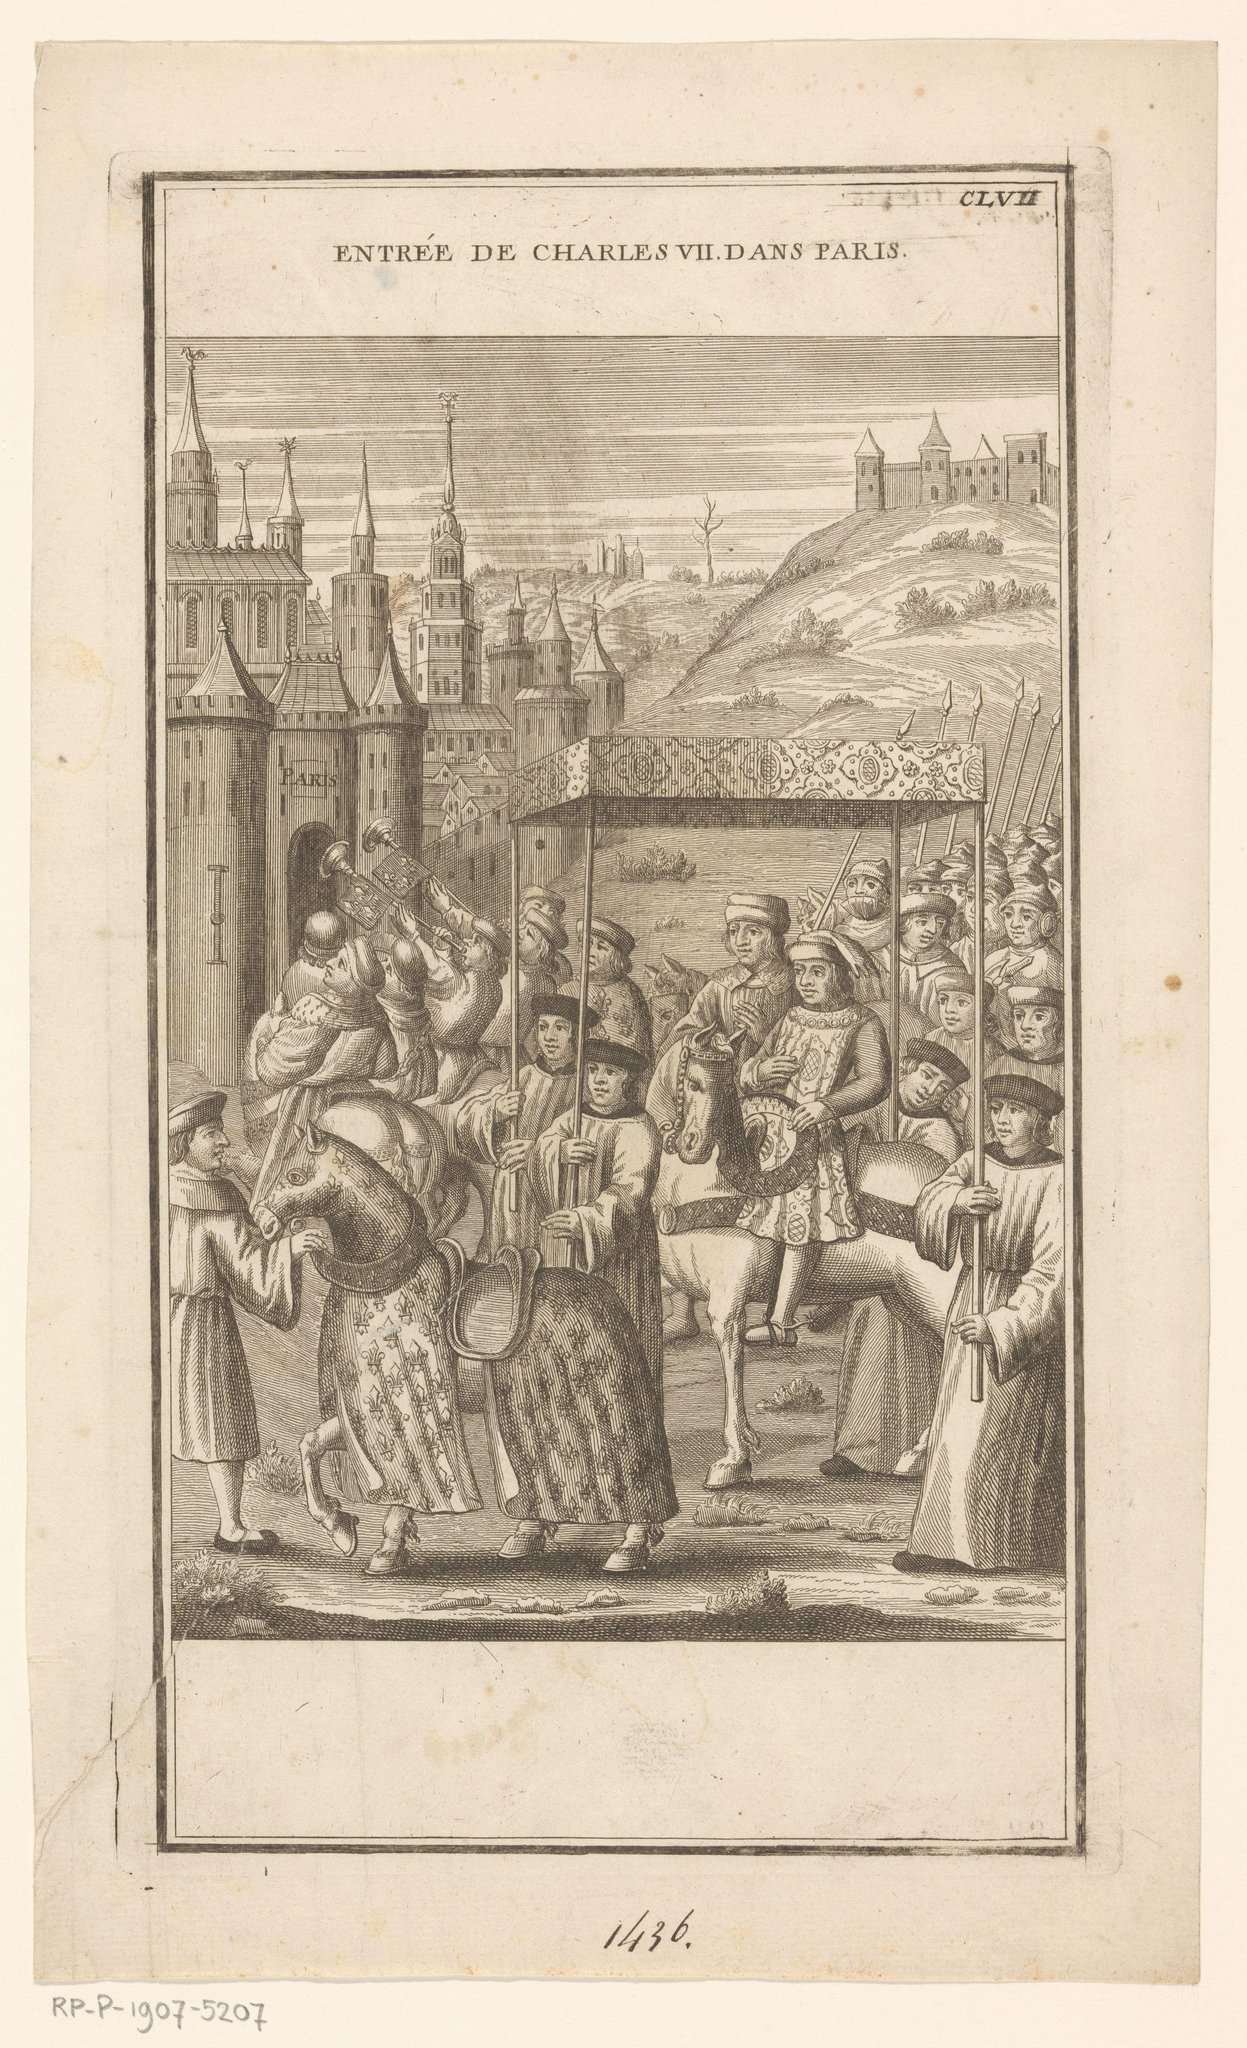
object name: print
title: Inkomst van koning Karel VII in Parijs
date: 1729-1733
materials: paper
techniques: engraving, etching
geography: paris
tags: paris, king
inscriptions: number: ‘1436’, collector's mark: Lugt 2228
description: Prent uit: Montfaucon, Bernard de. Les monumens de la monarchie françoise, qui comprennent l'histoire de France avec les figures de chaque règne que l'injure des tems a épargnées (...). Parijs: Julien-Michel Gandouin en Pierre-François Giffart, 1729-1733, dl. 3, afb. voor p. 221.